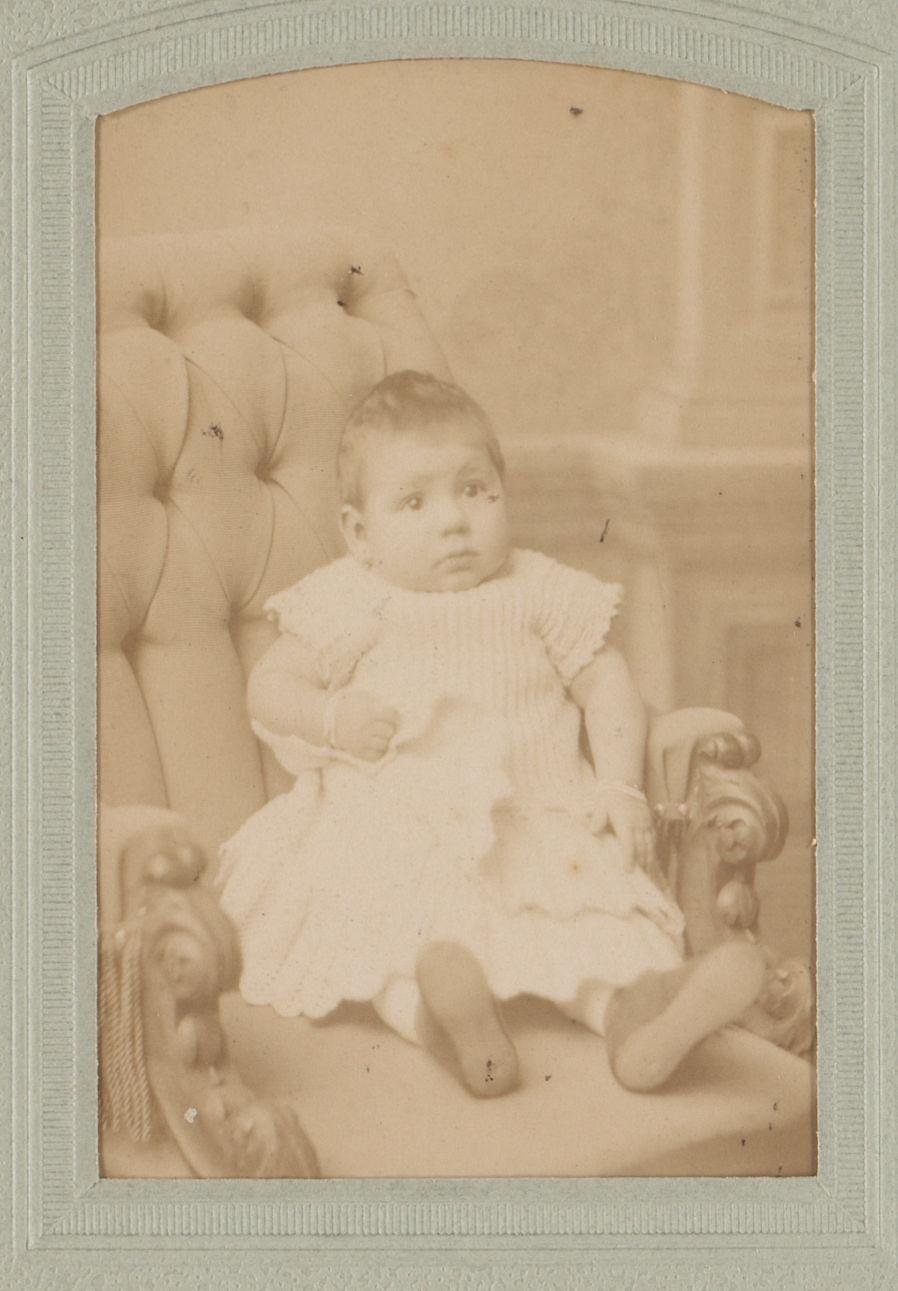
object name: carte de visite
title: Portret van een baby op een stoel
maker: albert greiner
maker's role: fotograaf, fotostudio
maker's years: 1833-1890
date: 1890-1910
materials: cardboard, photographic support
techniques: albumen print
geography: amsterdam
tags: historical persons, infant, baby